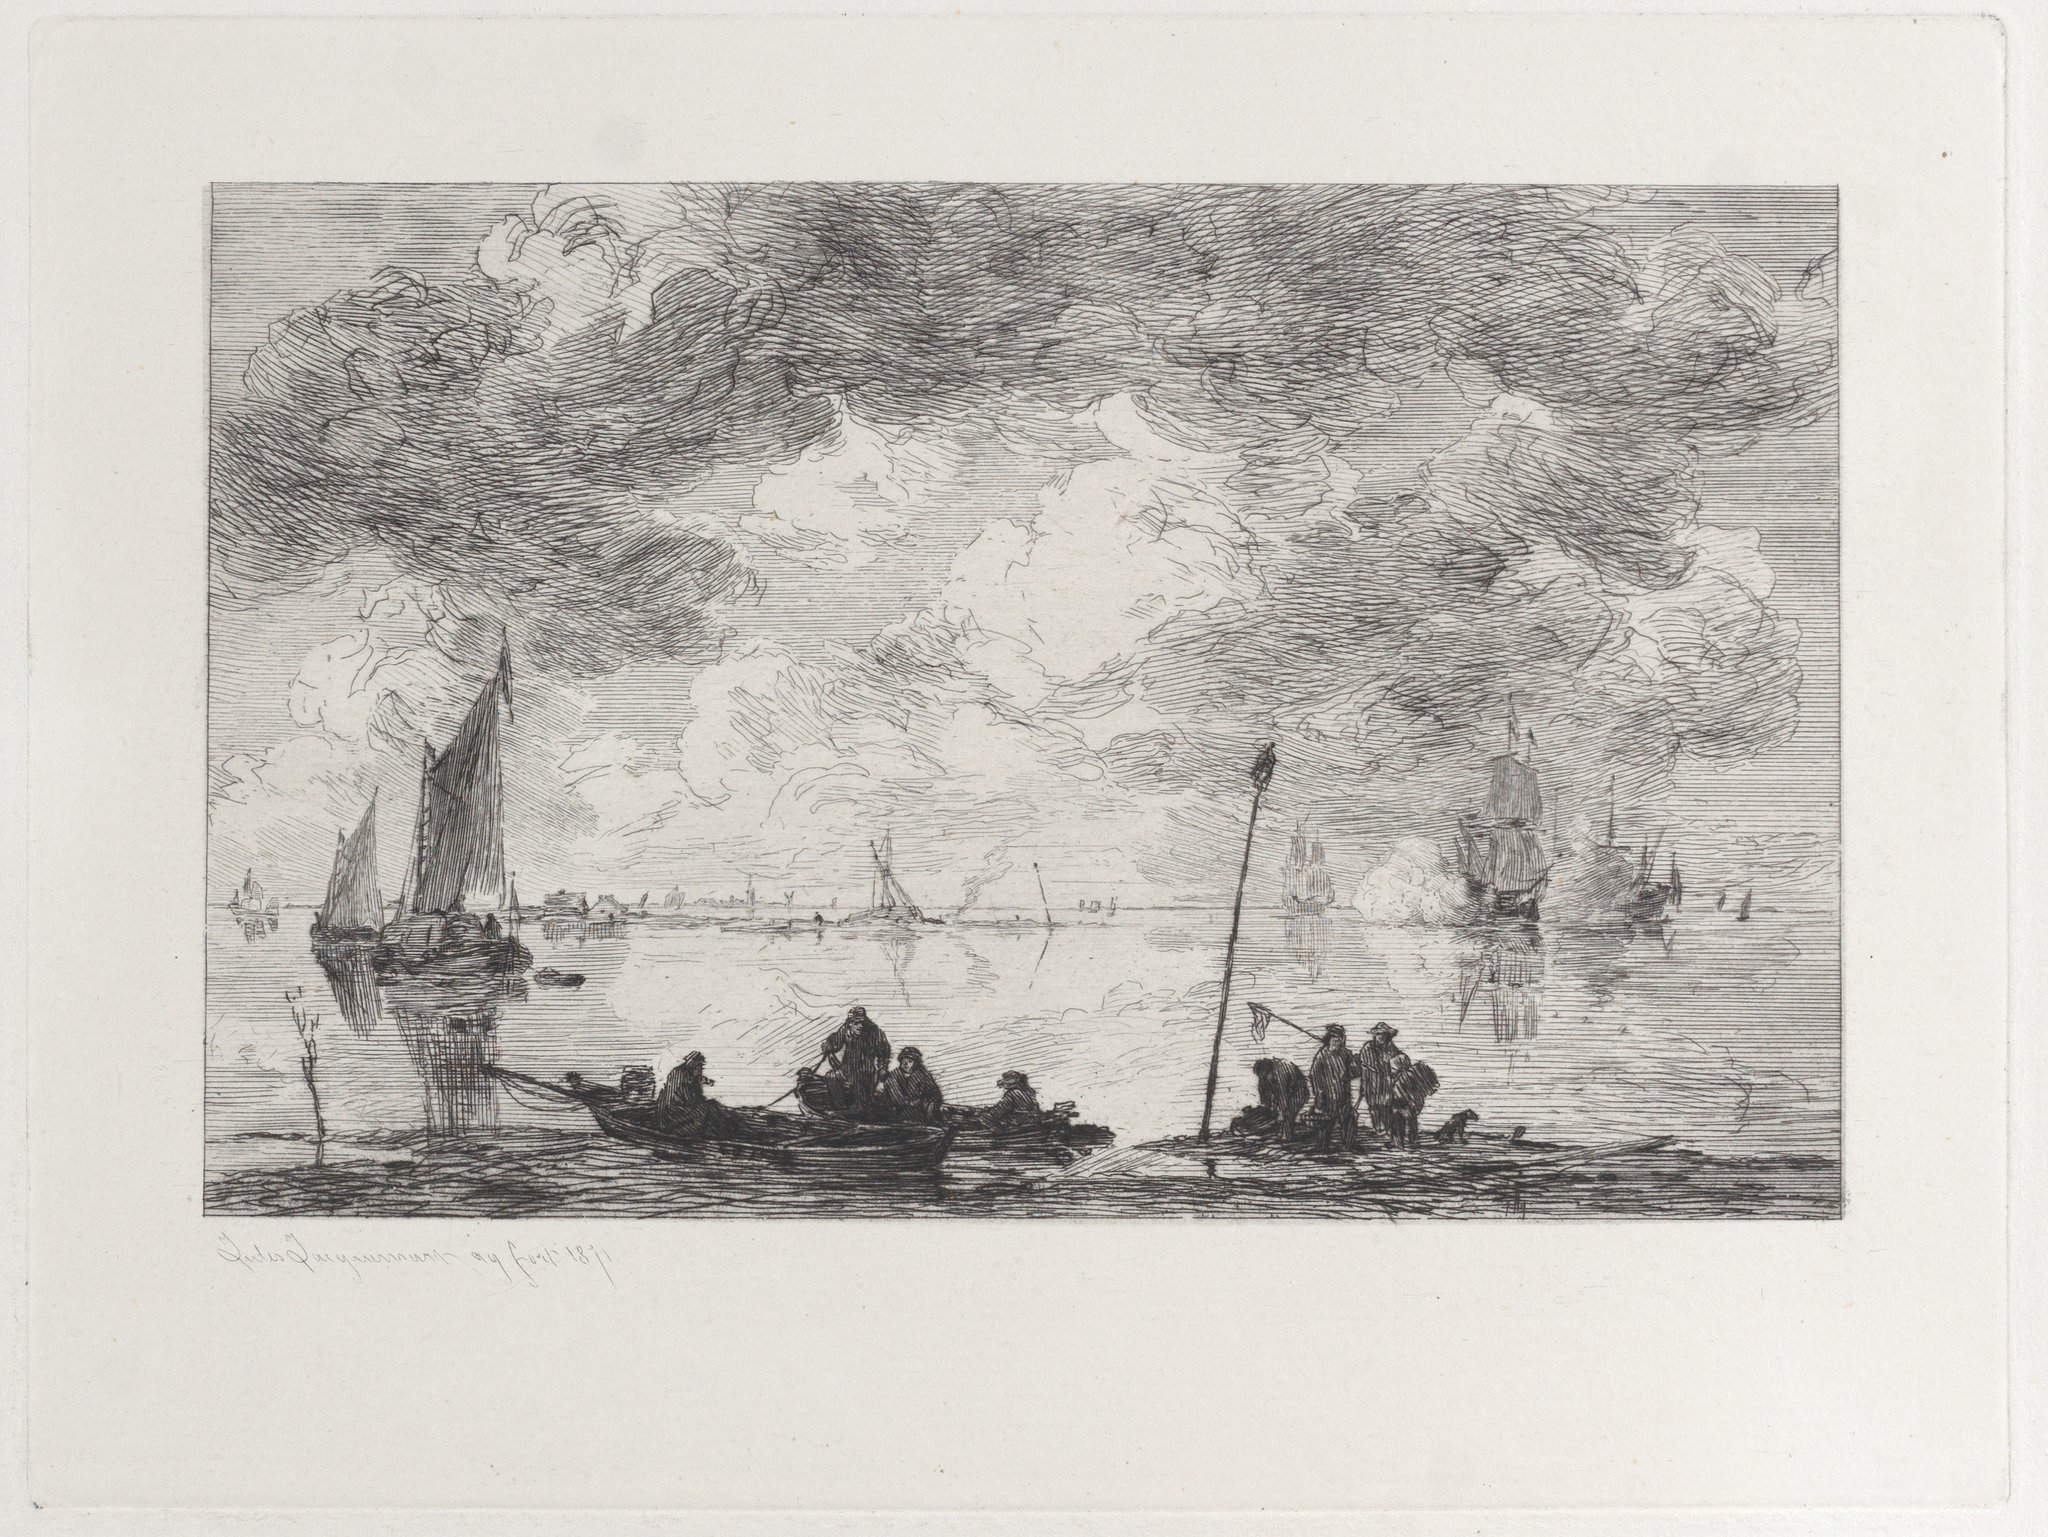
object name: print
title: The Moerdyck, after Jan van Goyen, from "Etchings of Pictures in the Metropolitan Museum New York"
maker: jules-ferdinand jacquemart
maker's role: artist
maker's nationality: french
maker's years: 1837-1880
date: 1871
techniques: etching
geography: london